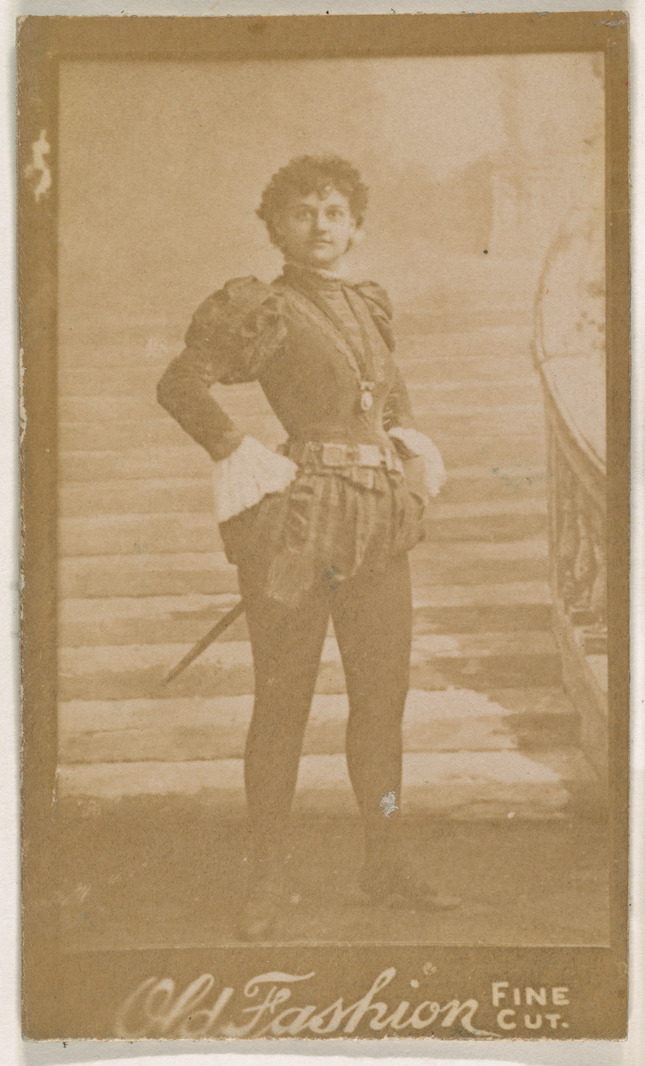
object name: photograph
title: Actress wearing costume with sword, from the Actresses series (N664) promoting Old Fashion Fine Cut Tobacco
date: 1888-1890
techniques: albumen silver print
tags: portraits,women,actresses